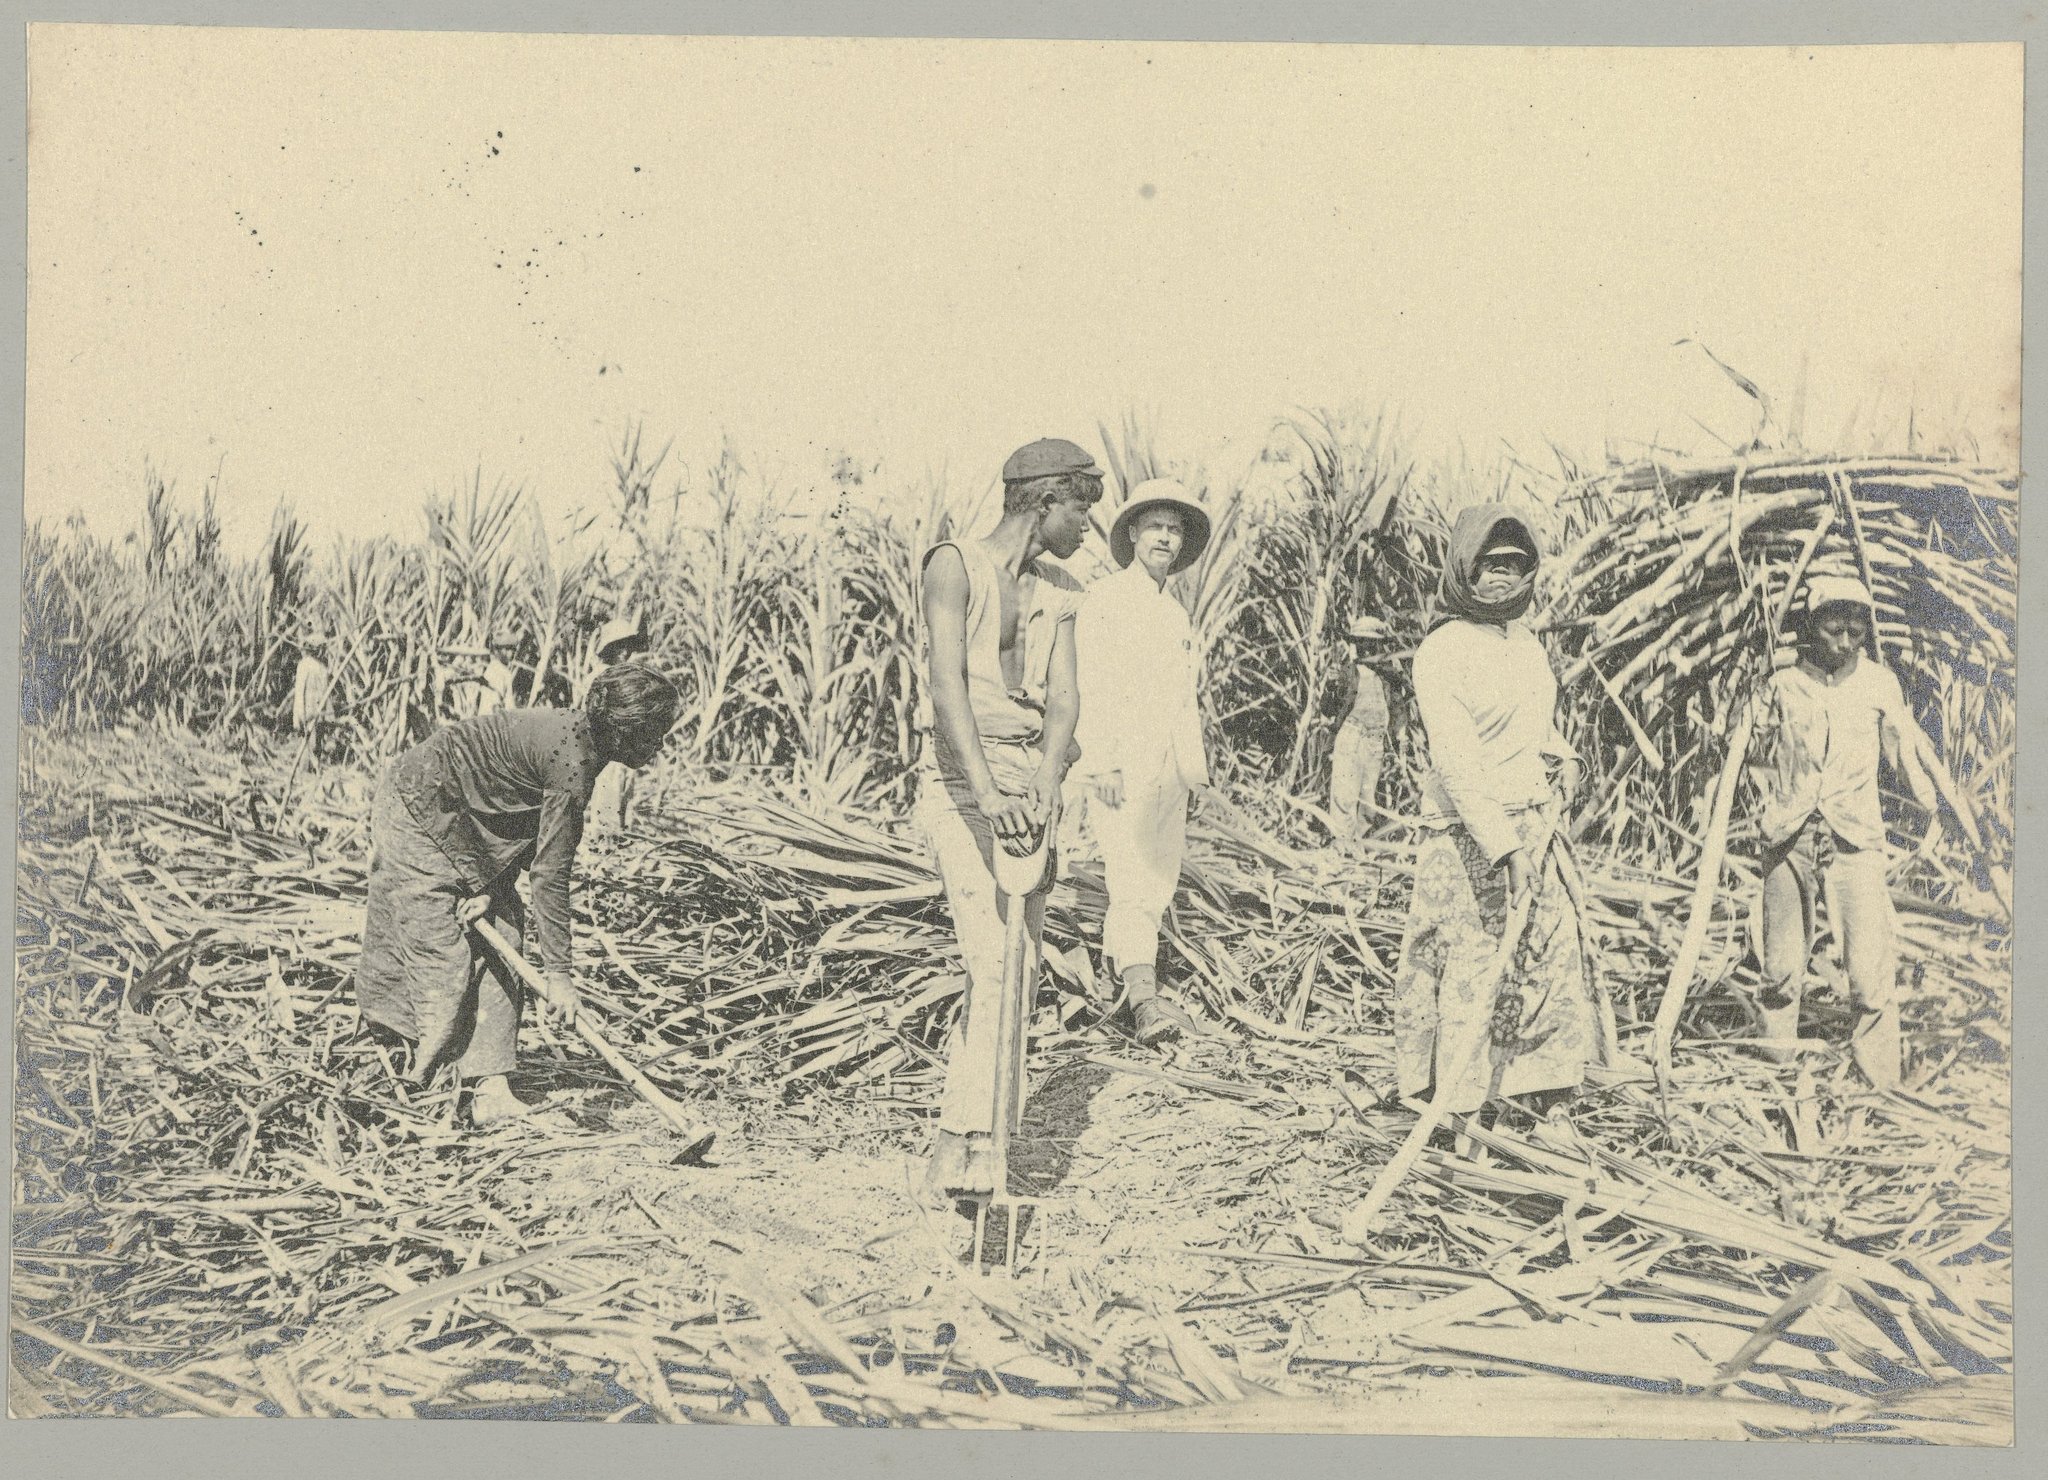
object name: photograph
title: Suikerrietveld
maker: moellaert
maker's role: fotograaf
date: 1906-1913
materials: photographic support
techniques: gelatin silver print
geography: suriname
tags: suriname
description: Werkers op een veld bezig met het oogsten van suikerriet. Onderdeel van het fotoalbum Souvenir de Voyage (deel 4), over het leven van de familie Dooyer in en rond de plantage Ma Retraite in Suriname in de jaren 1906-1913.